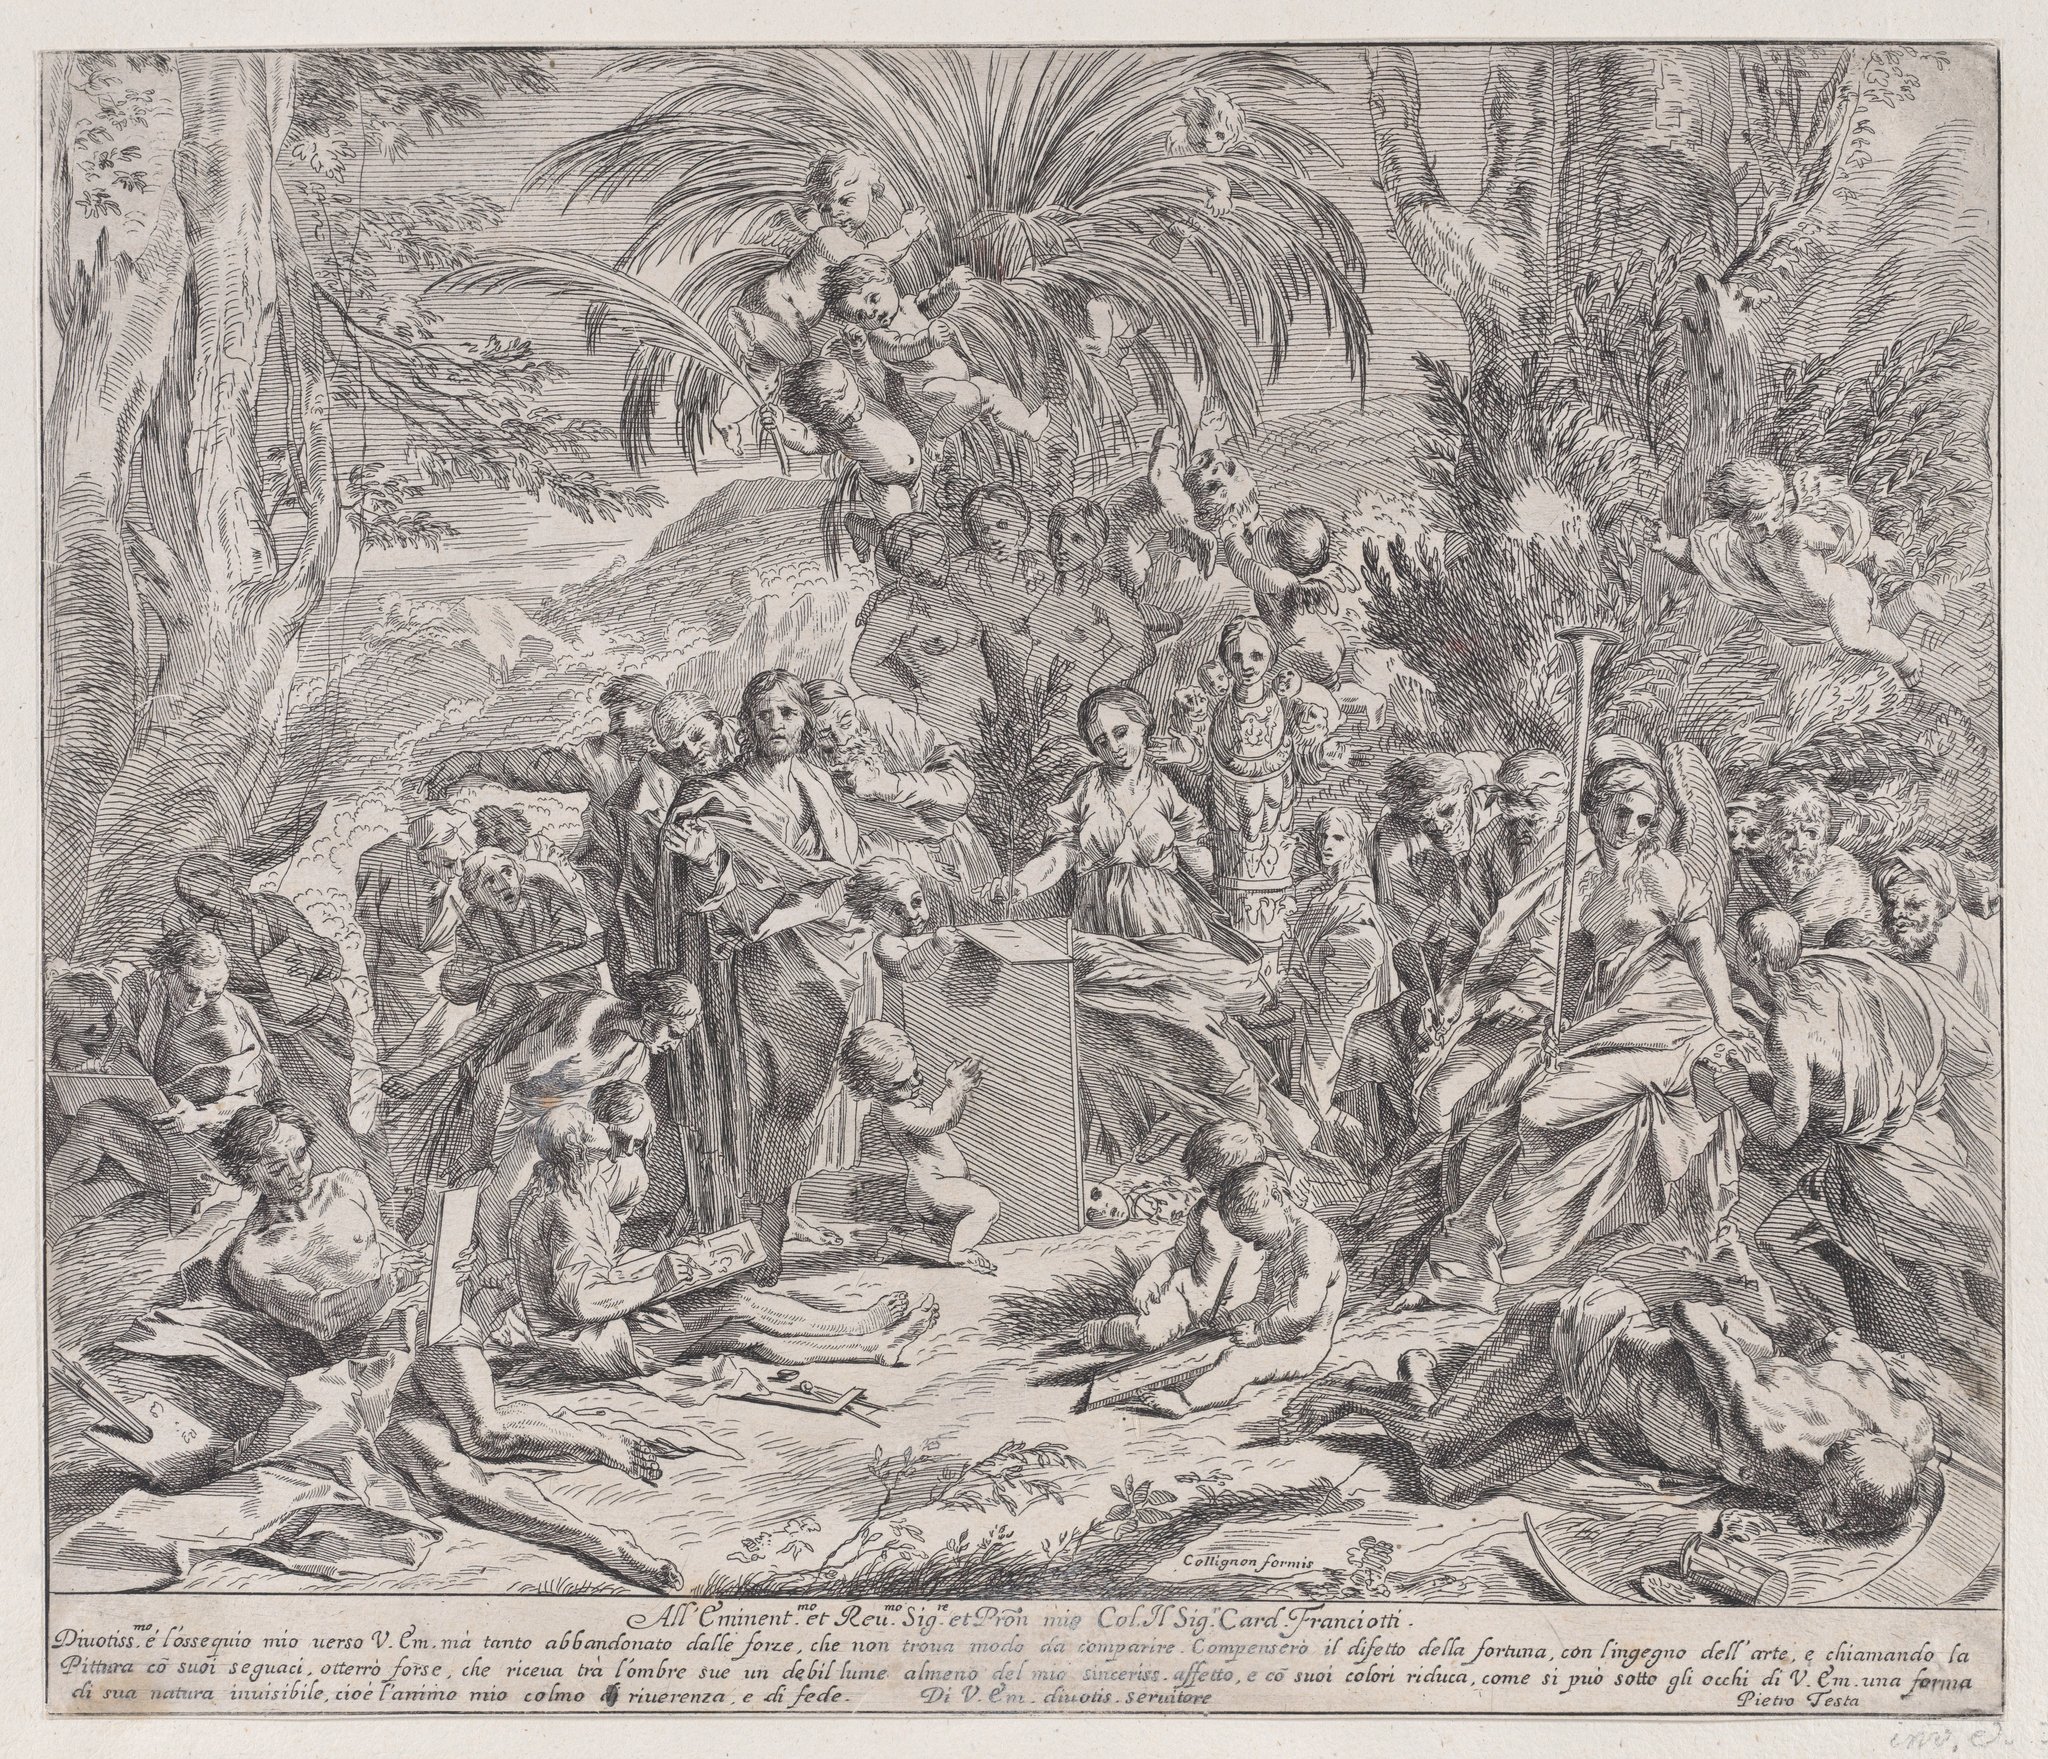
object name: print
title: An allegory of painting, who as an child in the centre left draws on a tablet, surrounded by figures, many of whom are drawing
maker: pietro testa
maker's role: artist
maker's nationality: italian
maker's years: 1612-1650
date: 1650-1700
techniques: etching